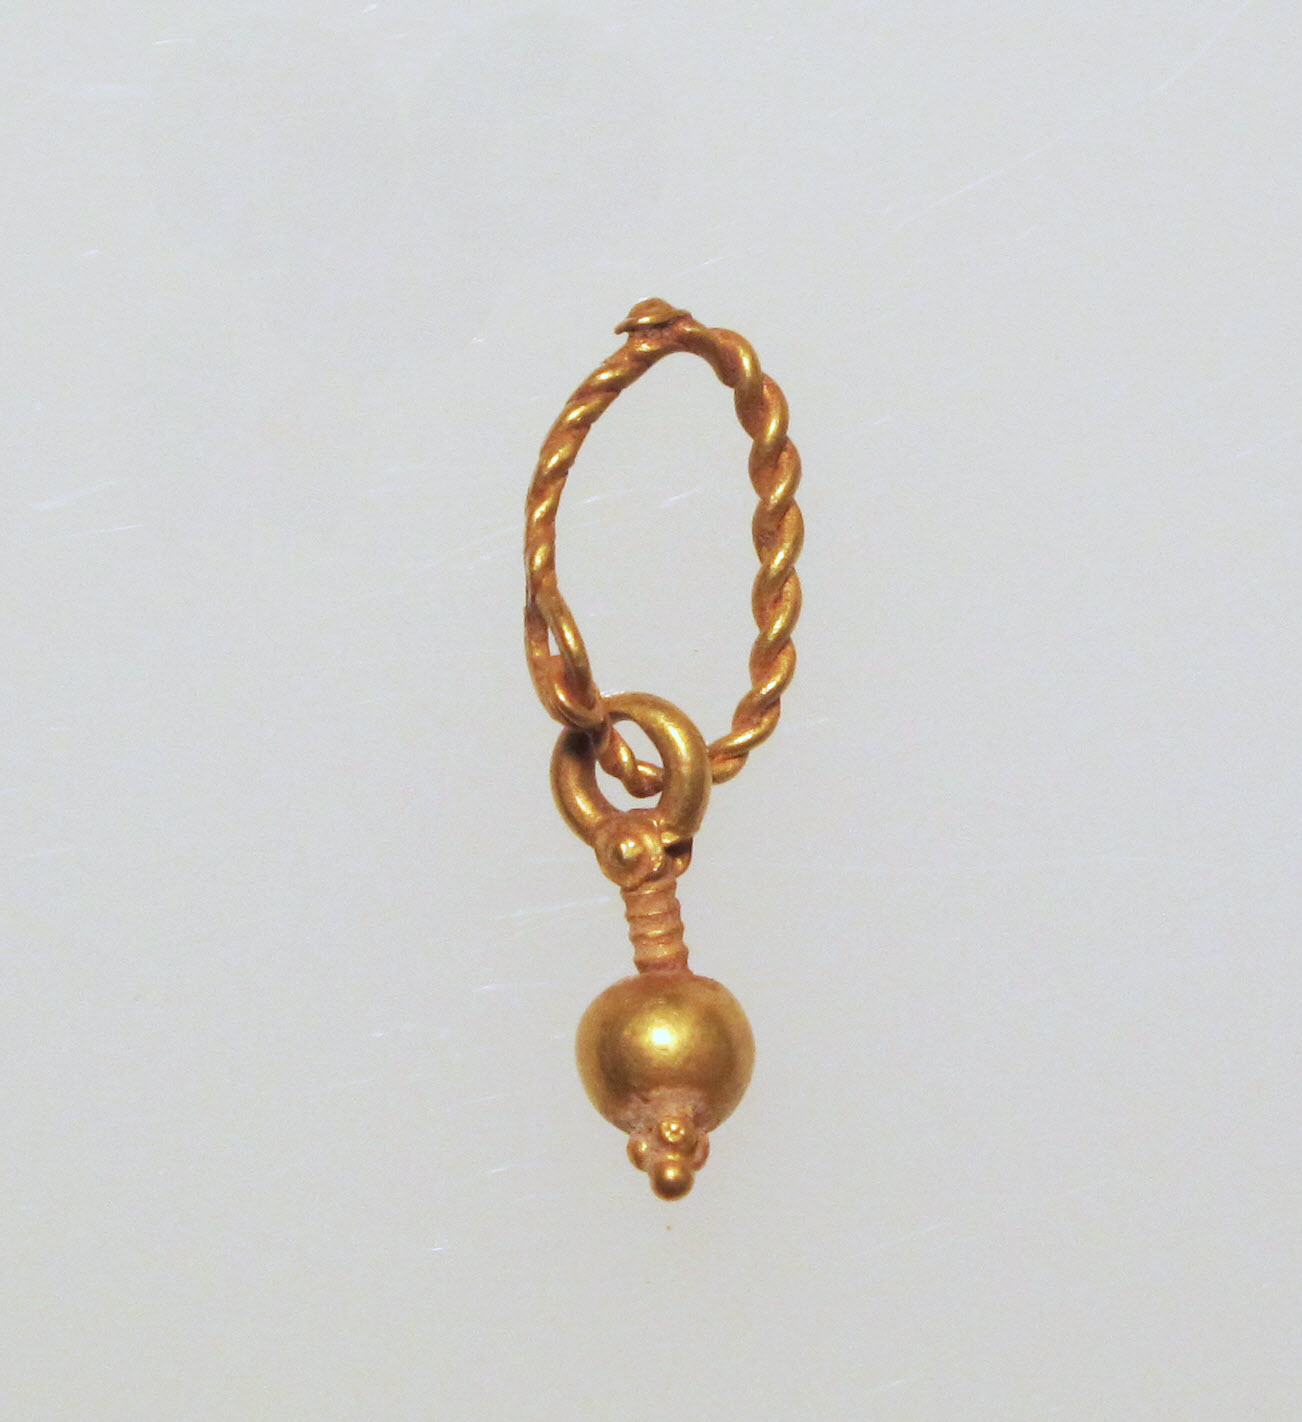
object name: earring with ball pendant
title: Gold earring with pendant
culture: roman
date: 101-200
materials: gold